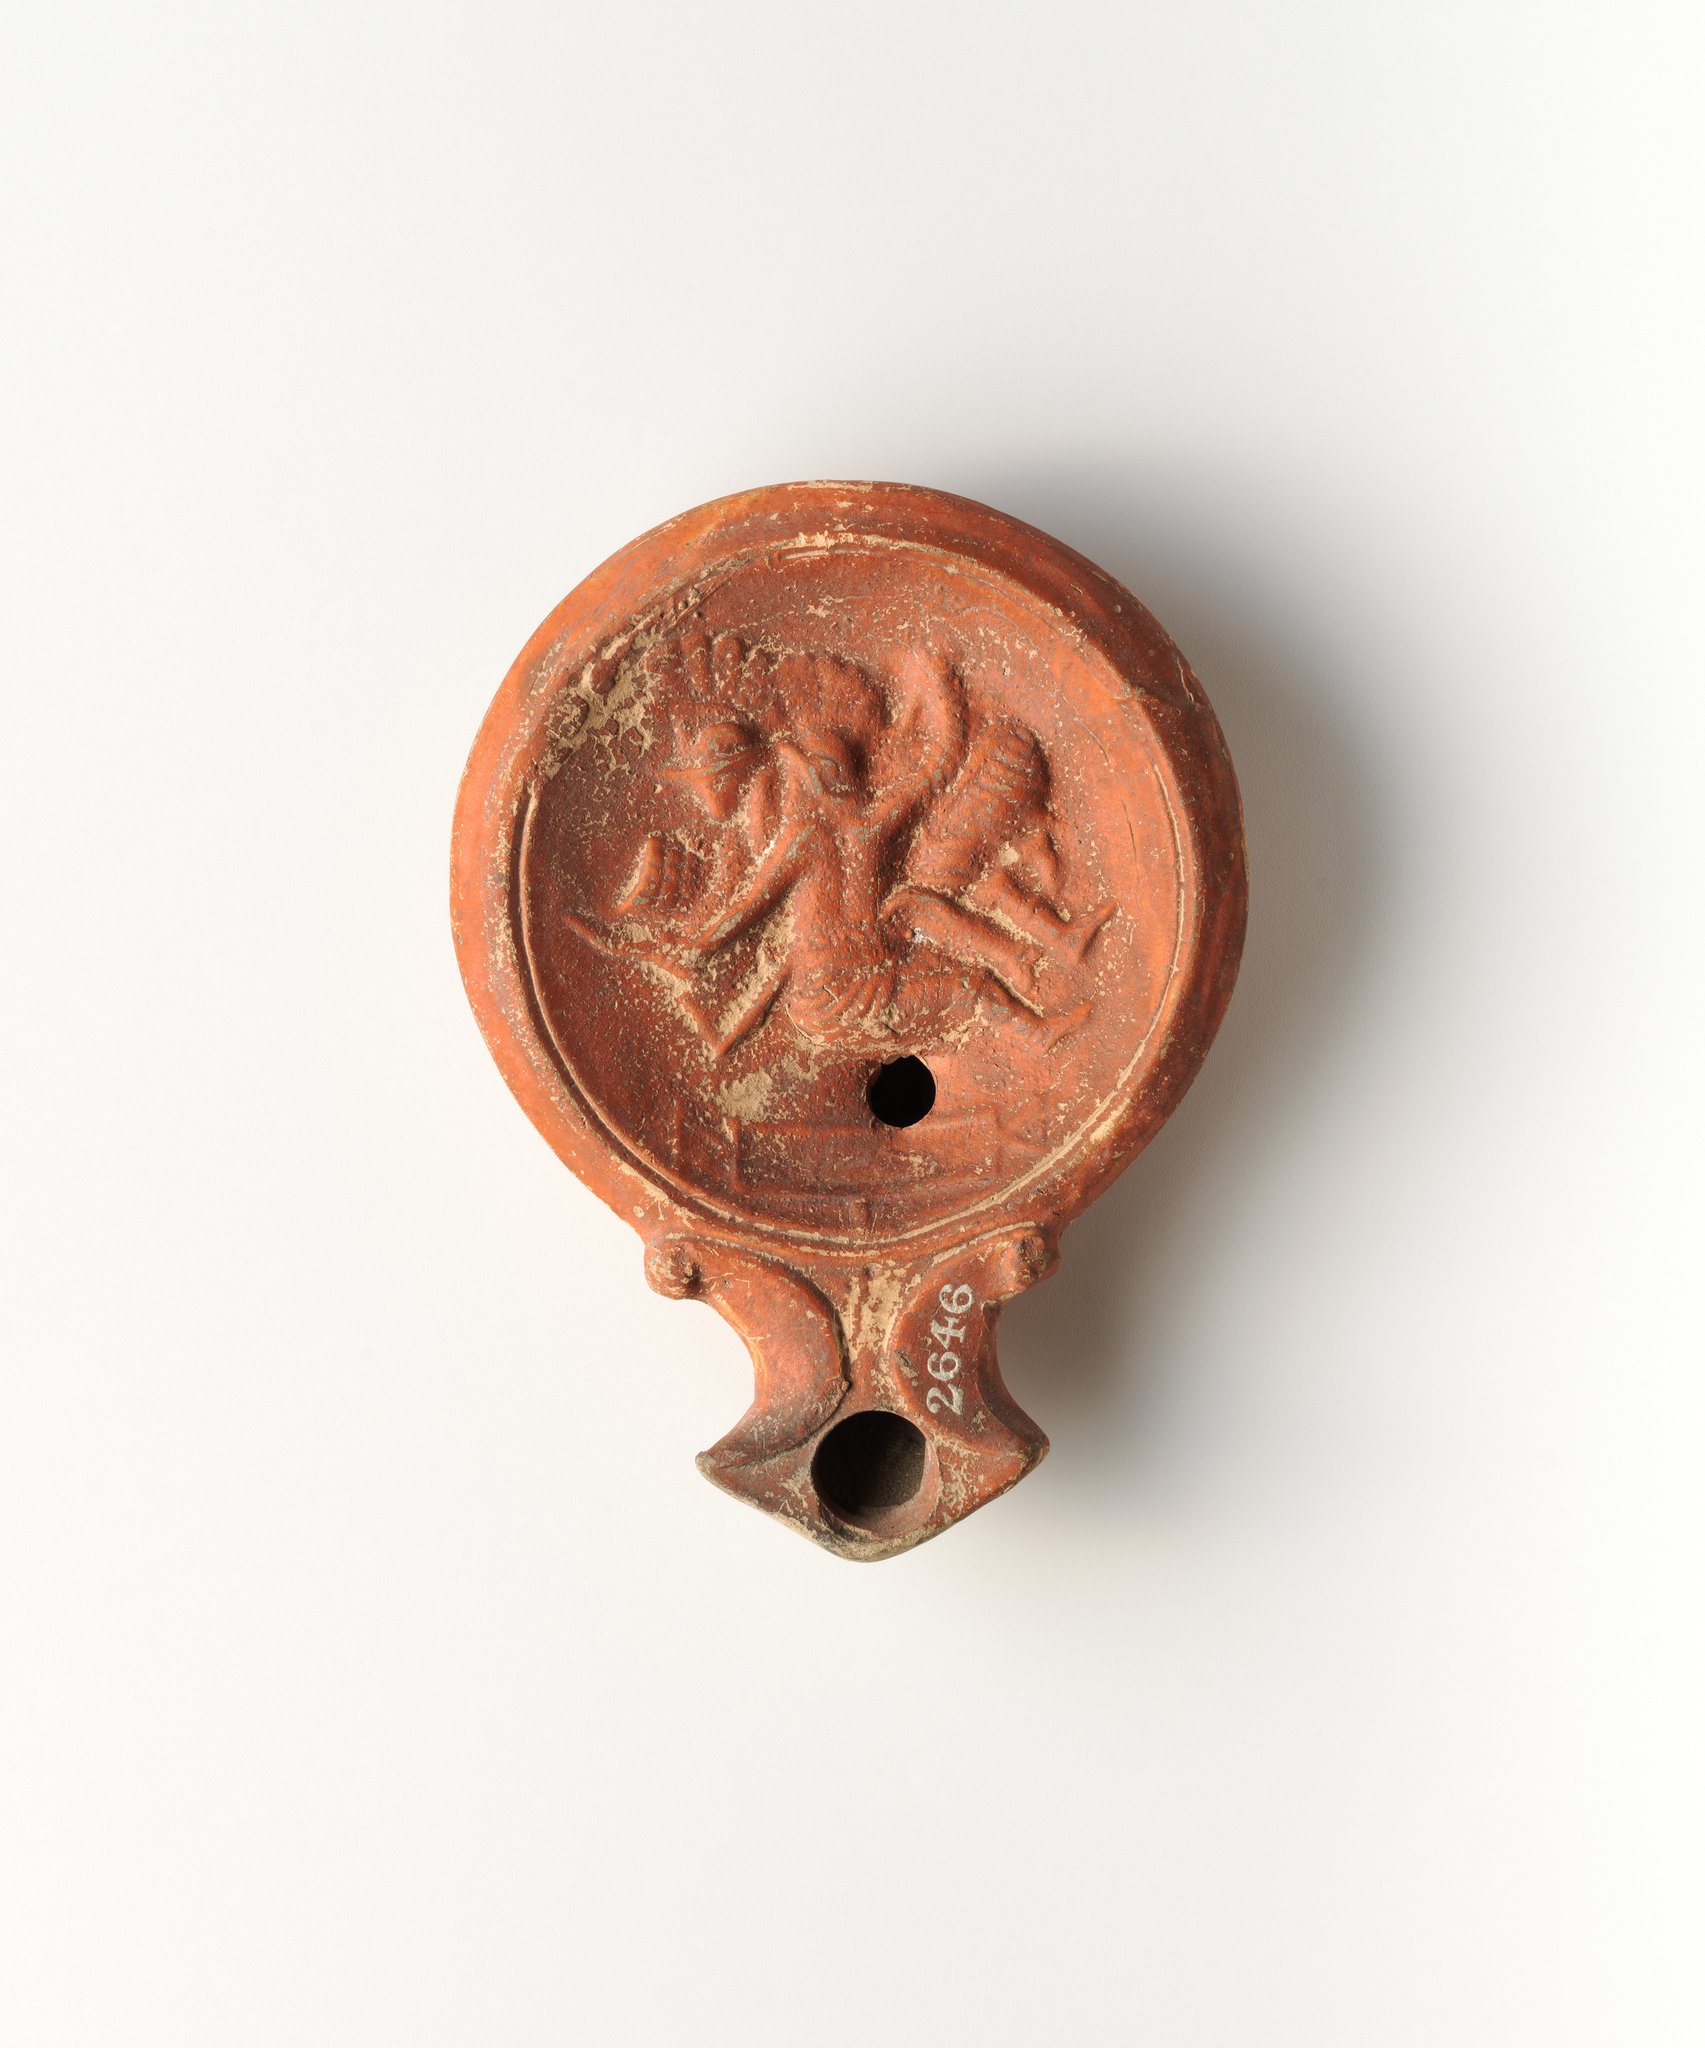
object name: lamp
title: Terracotta oil lamp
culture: roman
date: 1-100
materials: terracotta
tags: men,gladiators